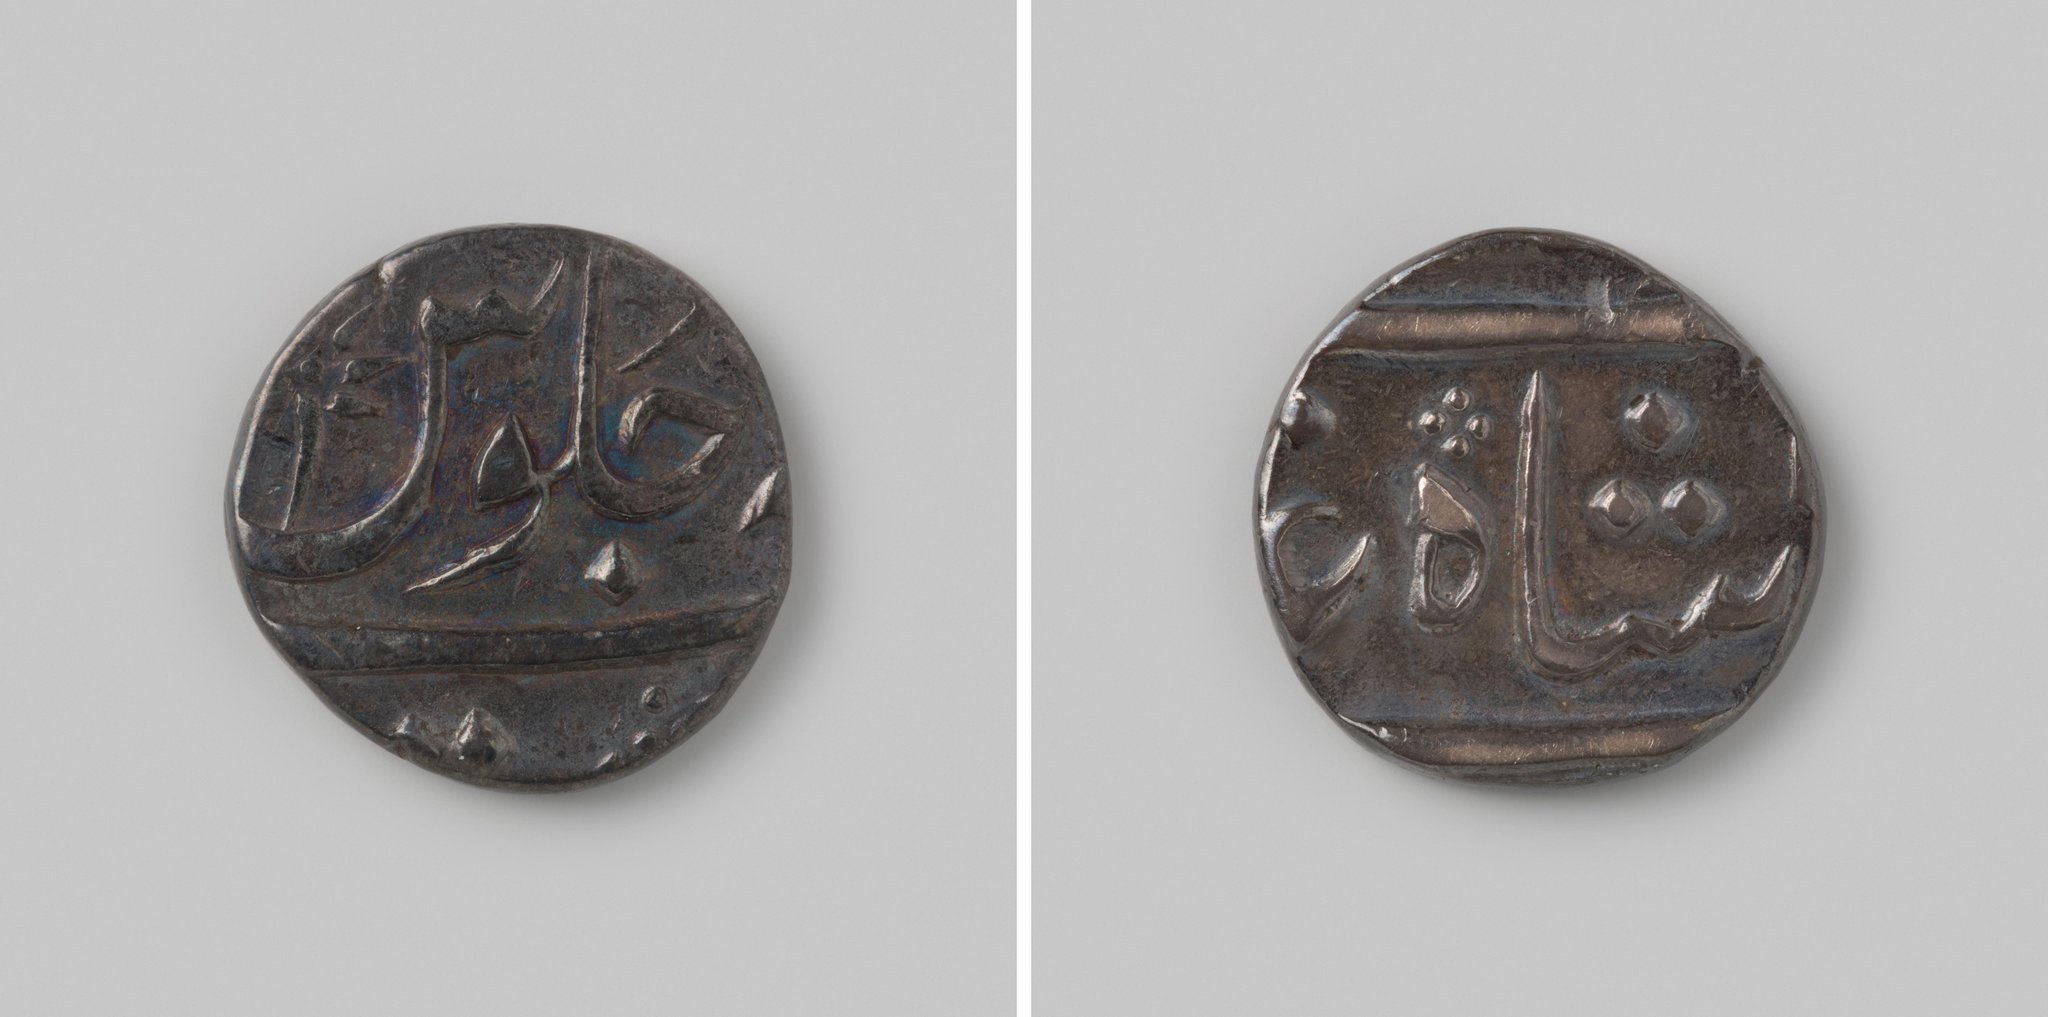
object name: coin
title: ½ Surat-roepie uit India van de Engelse Oostindische Compagnie (EIC), (1800-1820)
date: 1800-1820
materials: silver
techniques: striking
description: Zilveren munt. Voorzijde: in Arabische lettertekens in drie regels opschrift met op tweede regel naam: sjah Alem Keerzijde: in Arabische lettertekens in drie regels opschrift. Gladde rand.